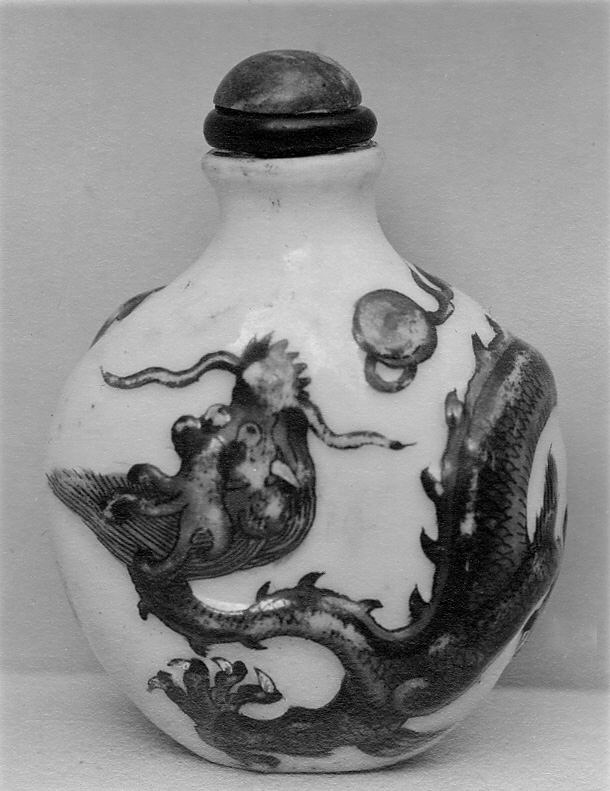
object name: snuff bottle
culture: chinese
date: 1736-1795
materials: porcelain, stone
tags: dragons